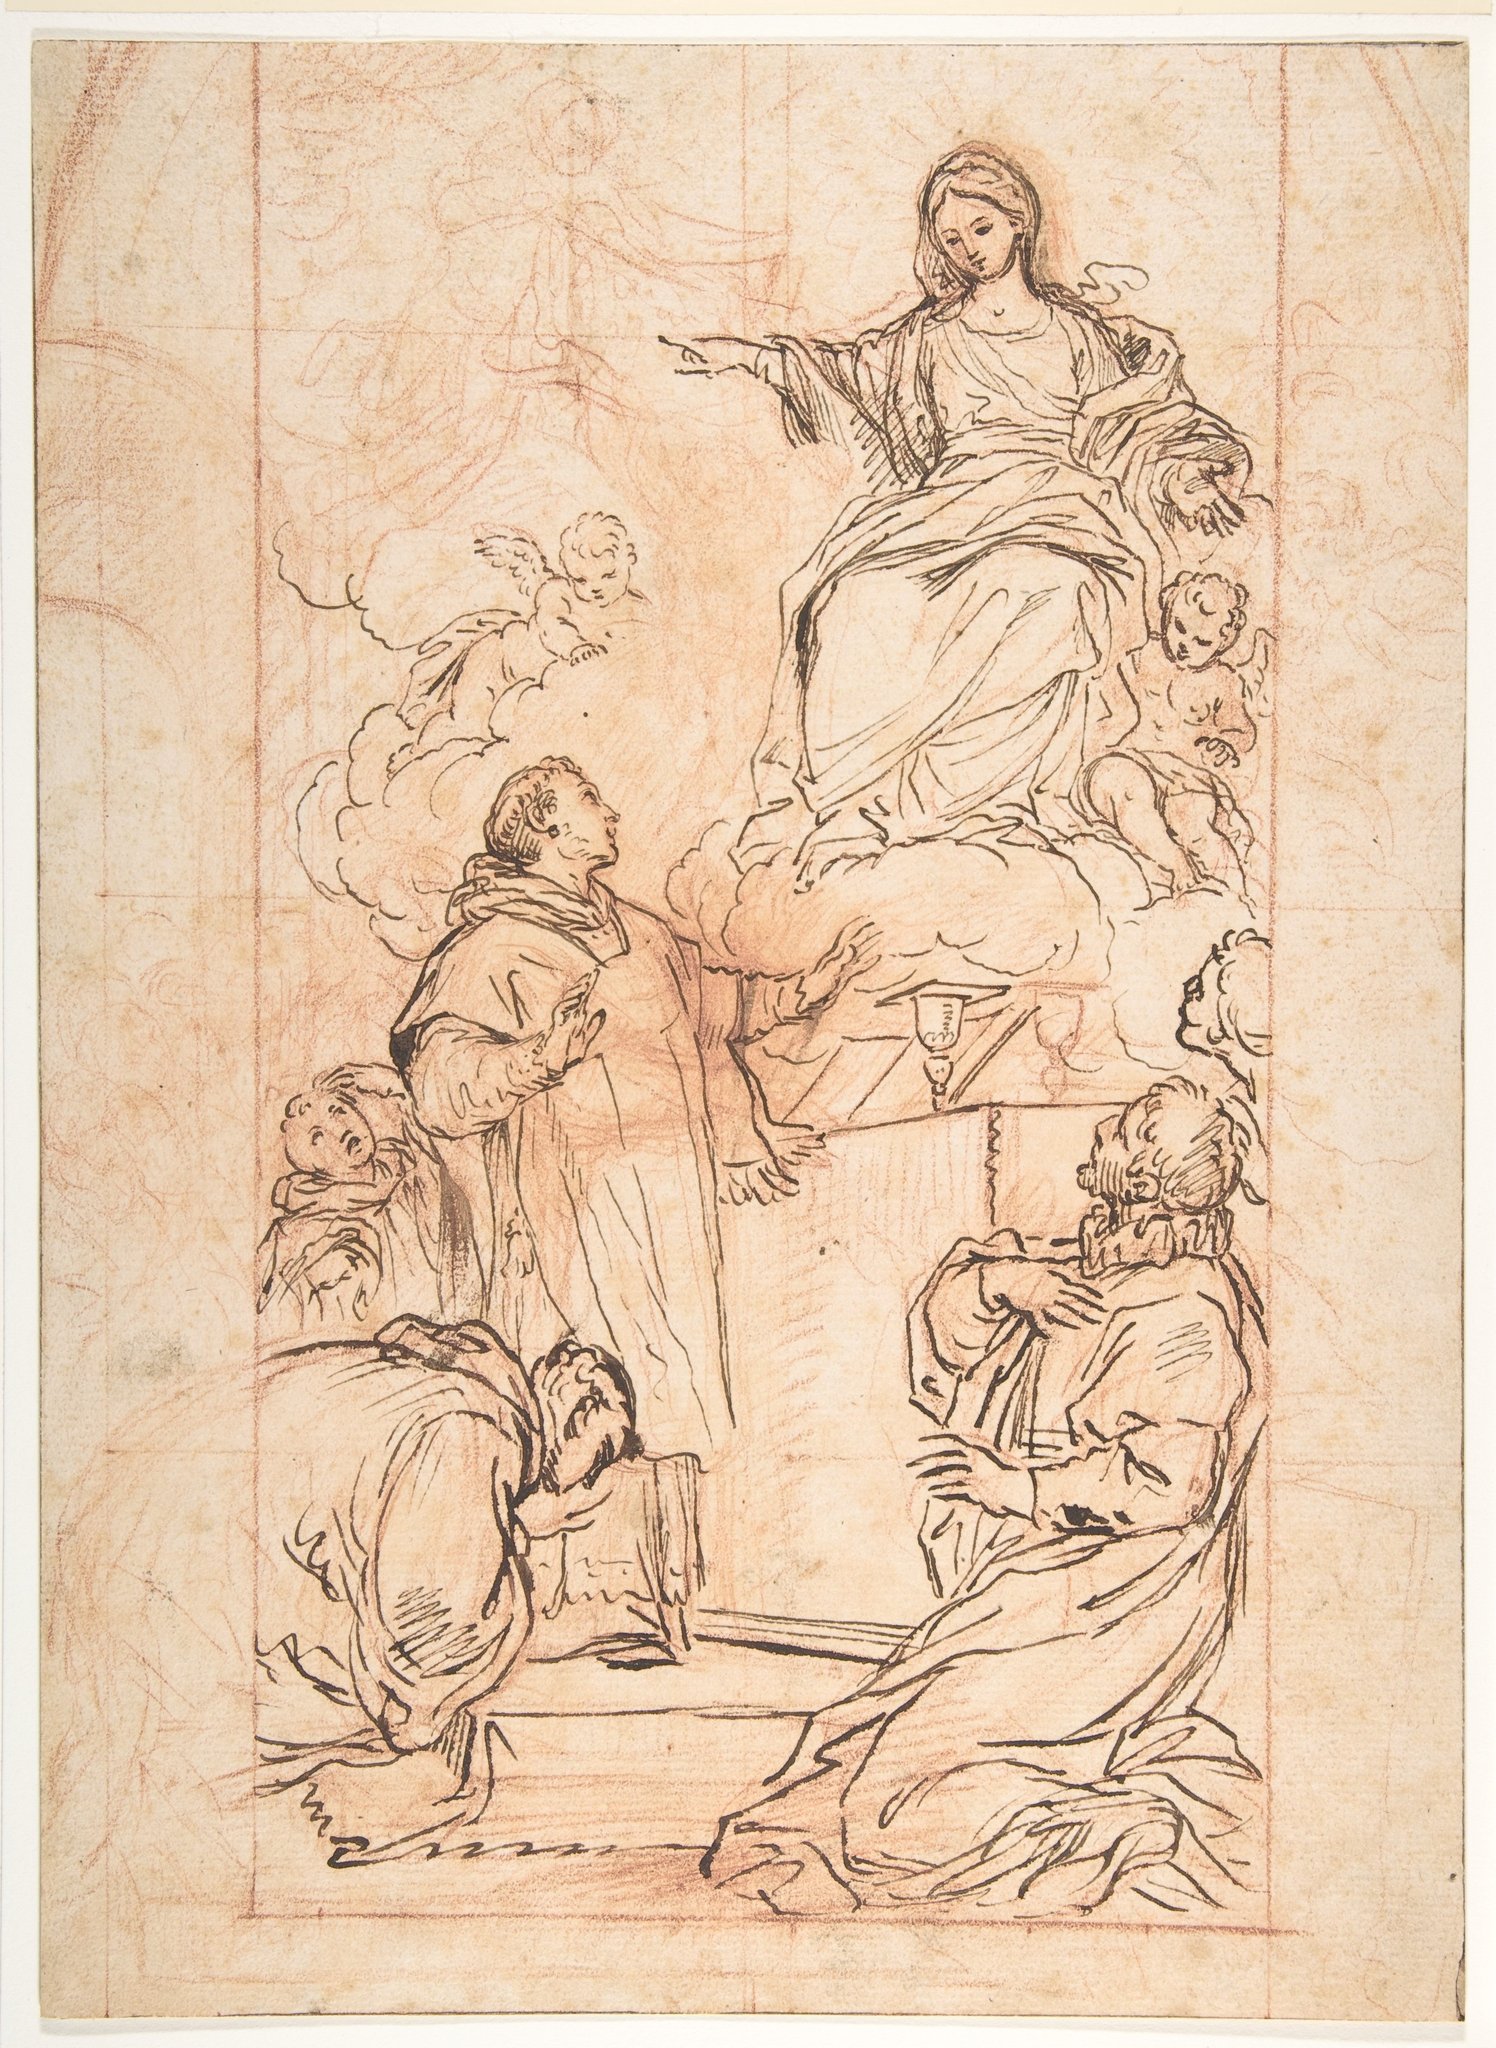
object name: drawing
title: The Virgin Appearing at Mass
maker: agostino masucci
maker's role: artist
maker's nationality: italian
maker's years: 1692-1768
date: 1692-1758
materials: chalk, ink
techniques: pen, drawing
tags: men,cupid,virgin mary